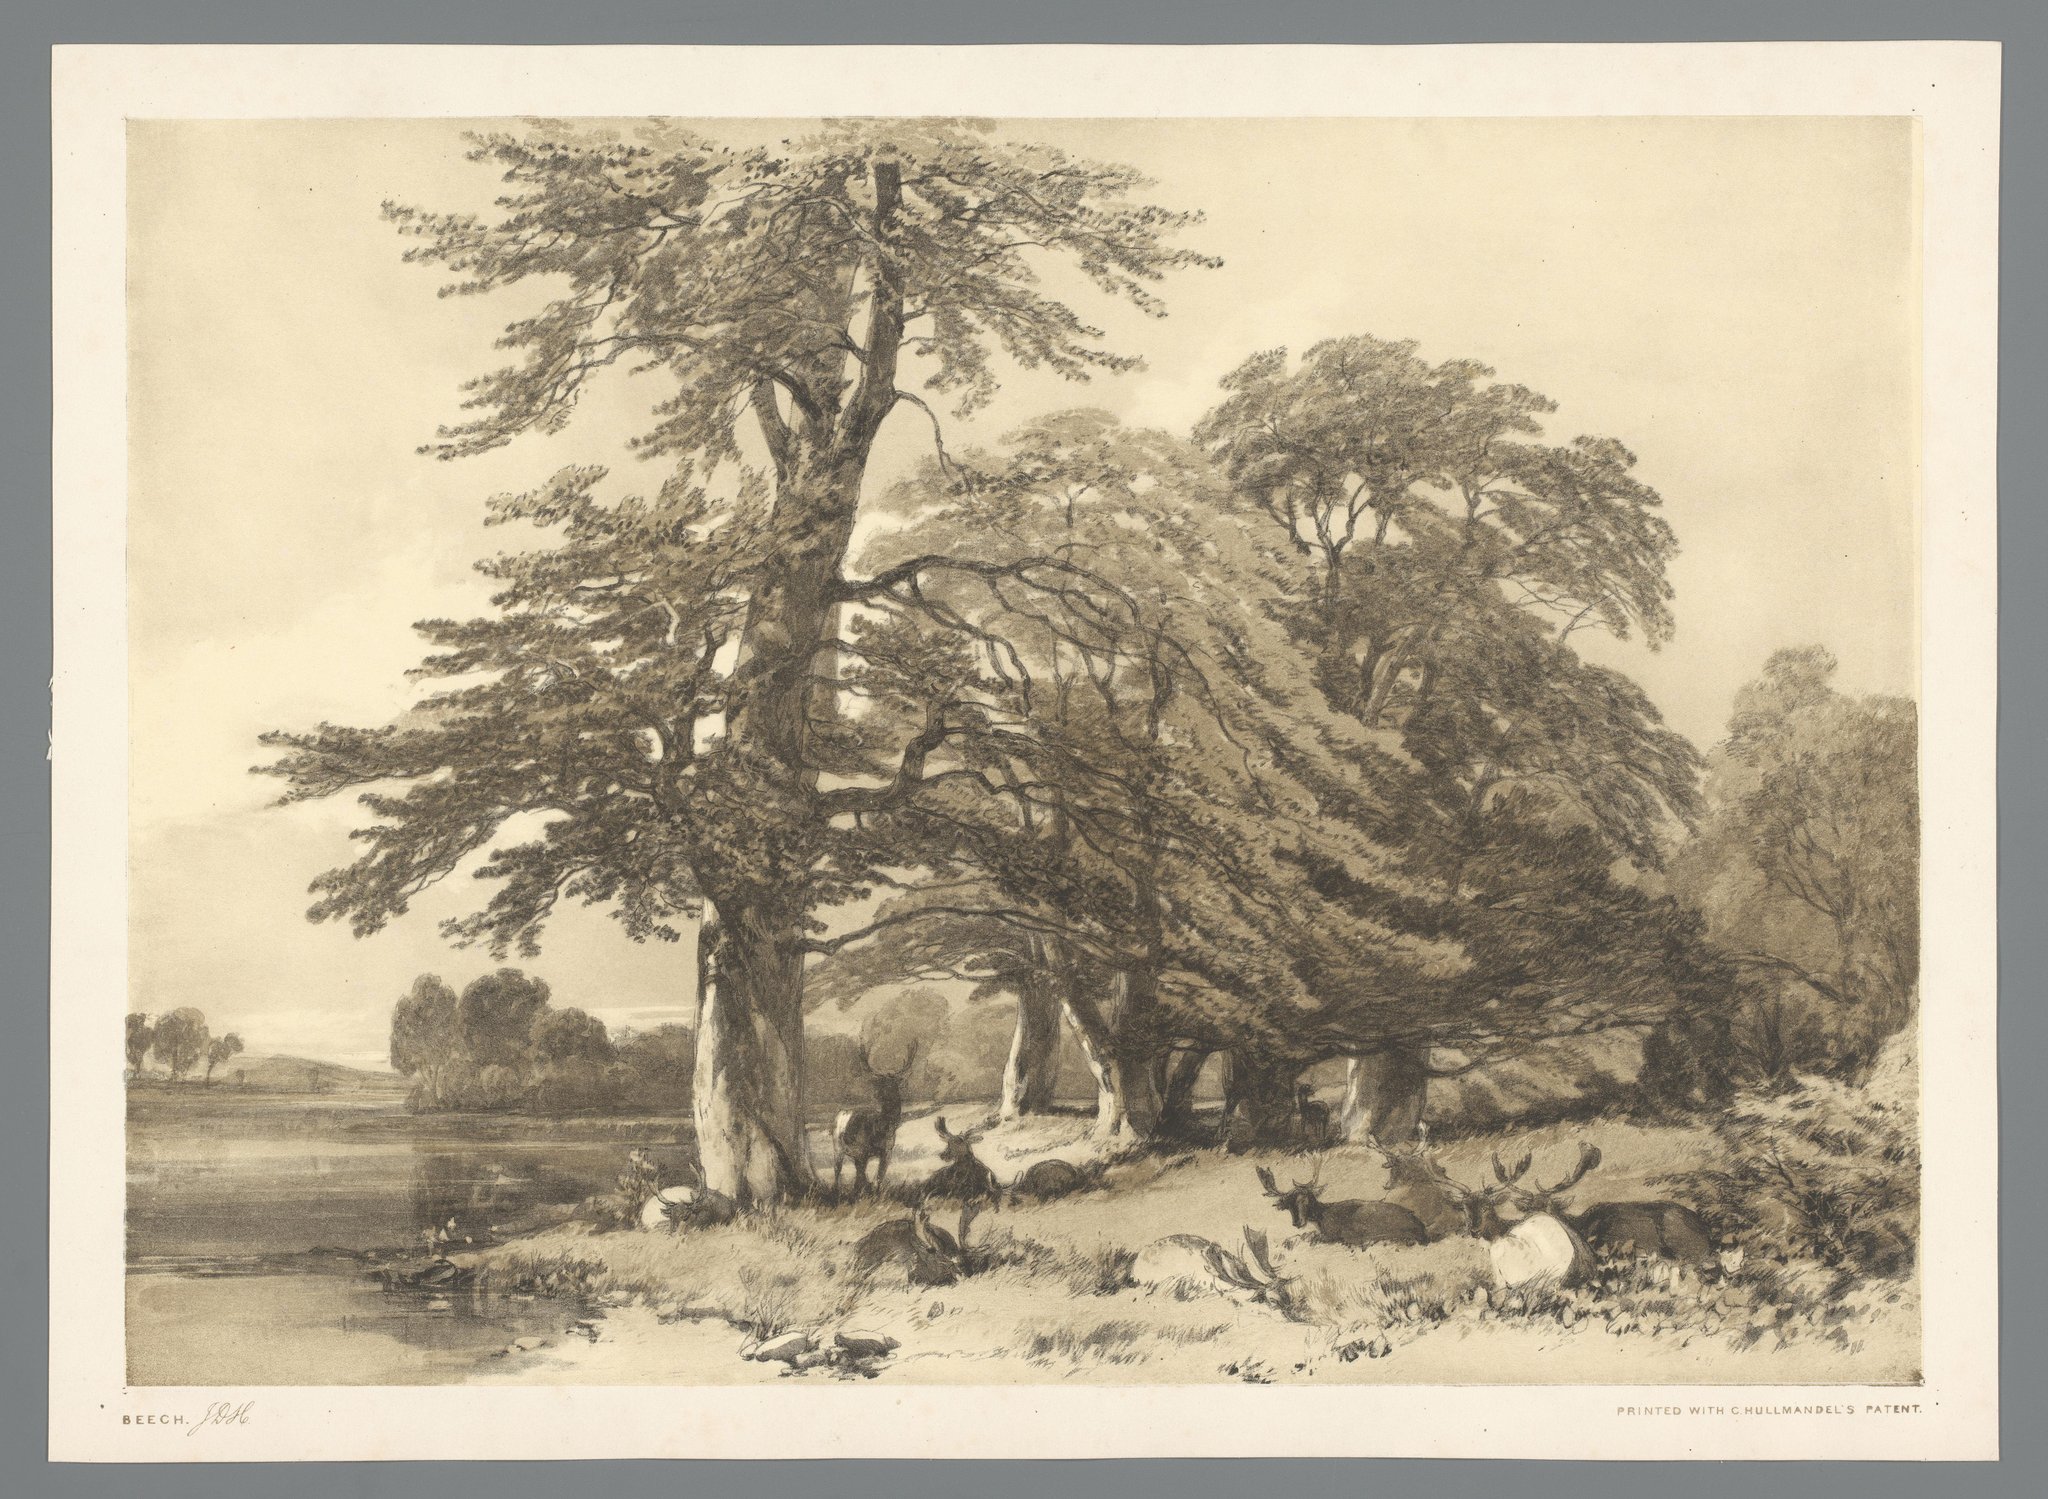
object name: print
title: Park en bos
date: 1841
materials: paper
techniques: tone lithography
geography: london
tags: park, hoofed animals: deer, river bank, forest, wood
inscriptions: collector's mark: Lugt 2228, collector's mark: Lugt 2760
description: Prent maakt deel uit van een serie van 24 prenten.